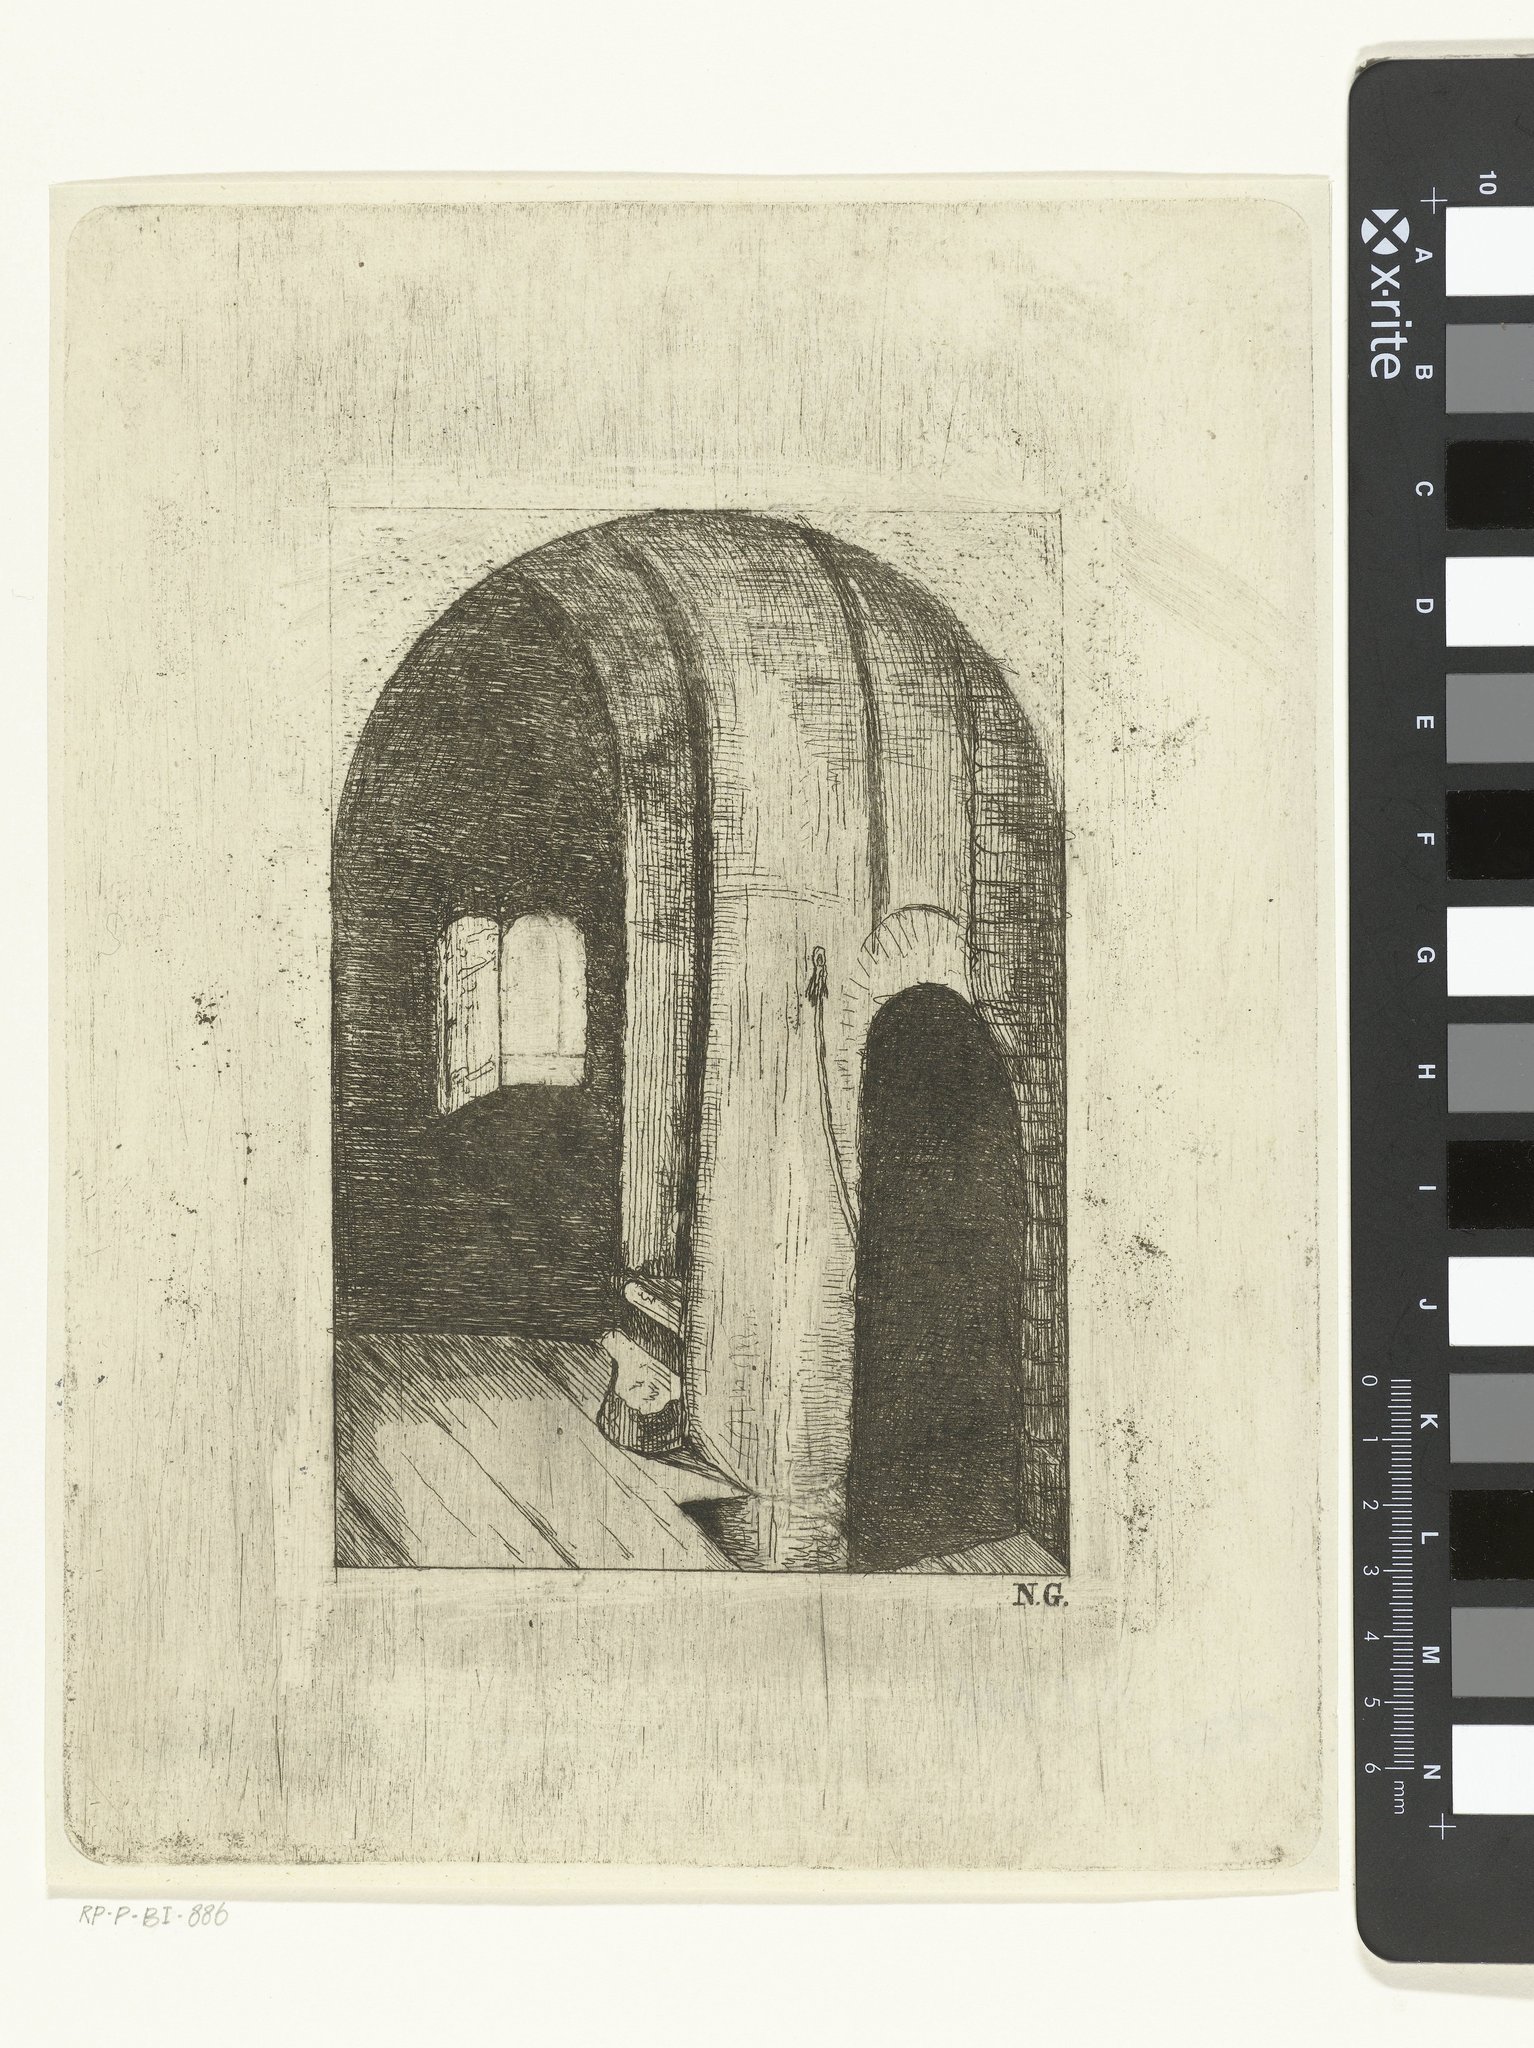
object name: print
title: Wenteltrap in toren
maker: jonkheer isaac lambertus cremer van den berch van heemstede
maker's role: print maker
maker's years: 1811-1879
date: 1821-1879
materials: paper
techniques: etching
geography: netherlands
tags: staircase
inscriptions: collector's mark: Lugt 2228, collector's mark: Lugt 1967